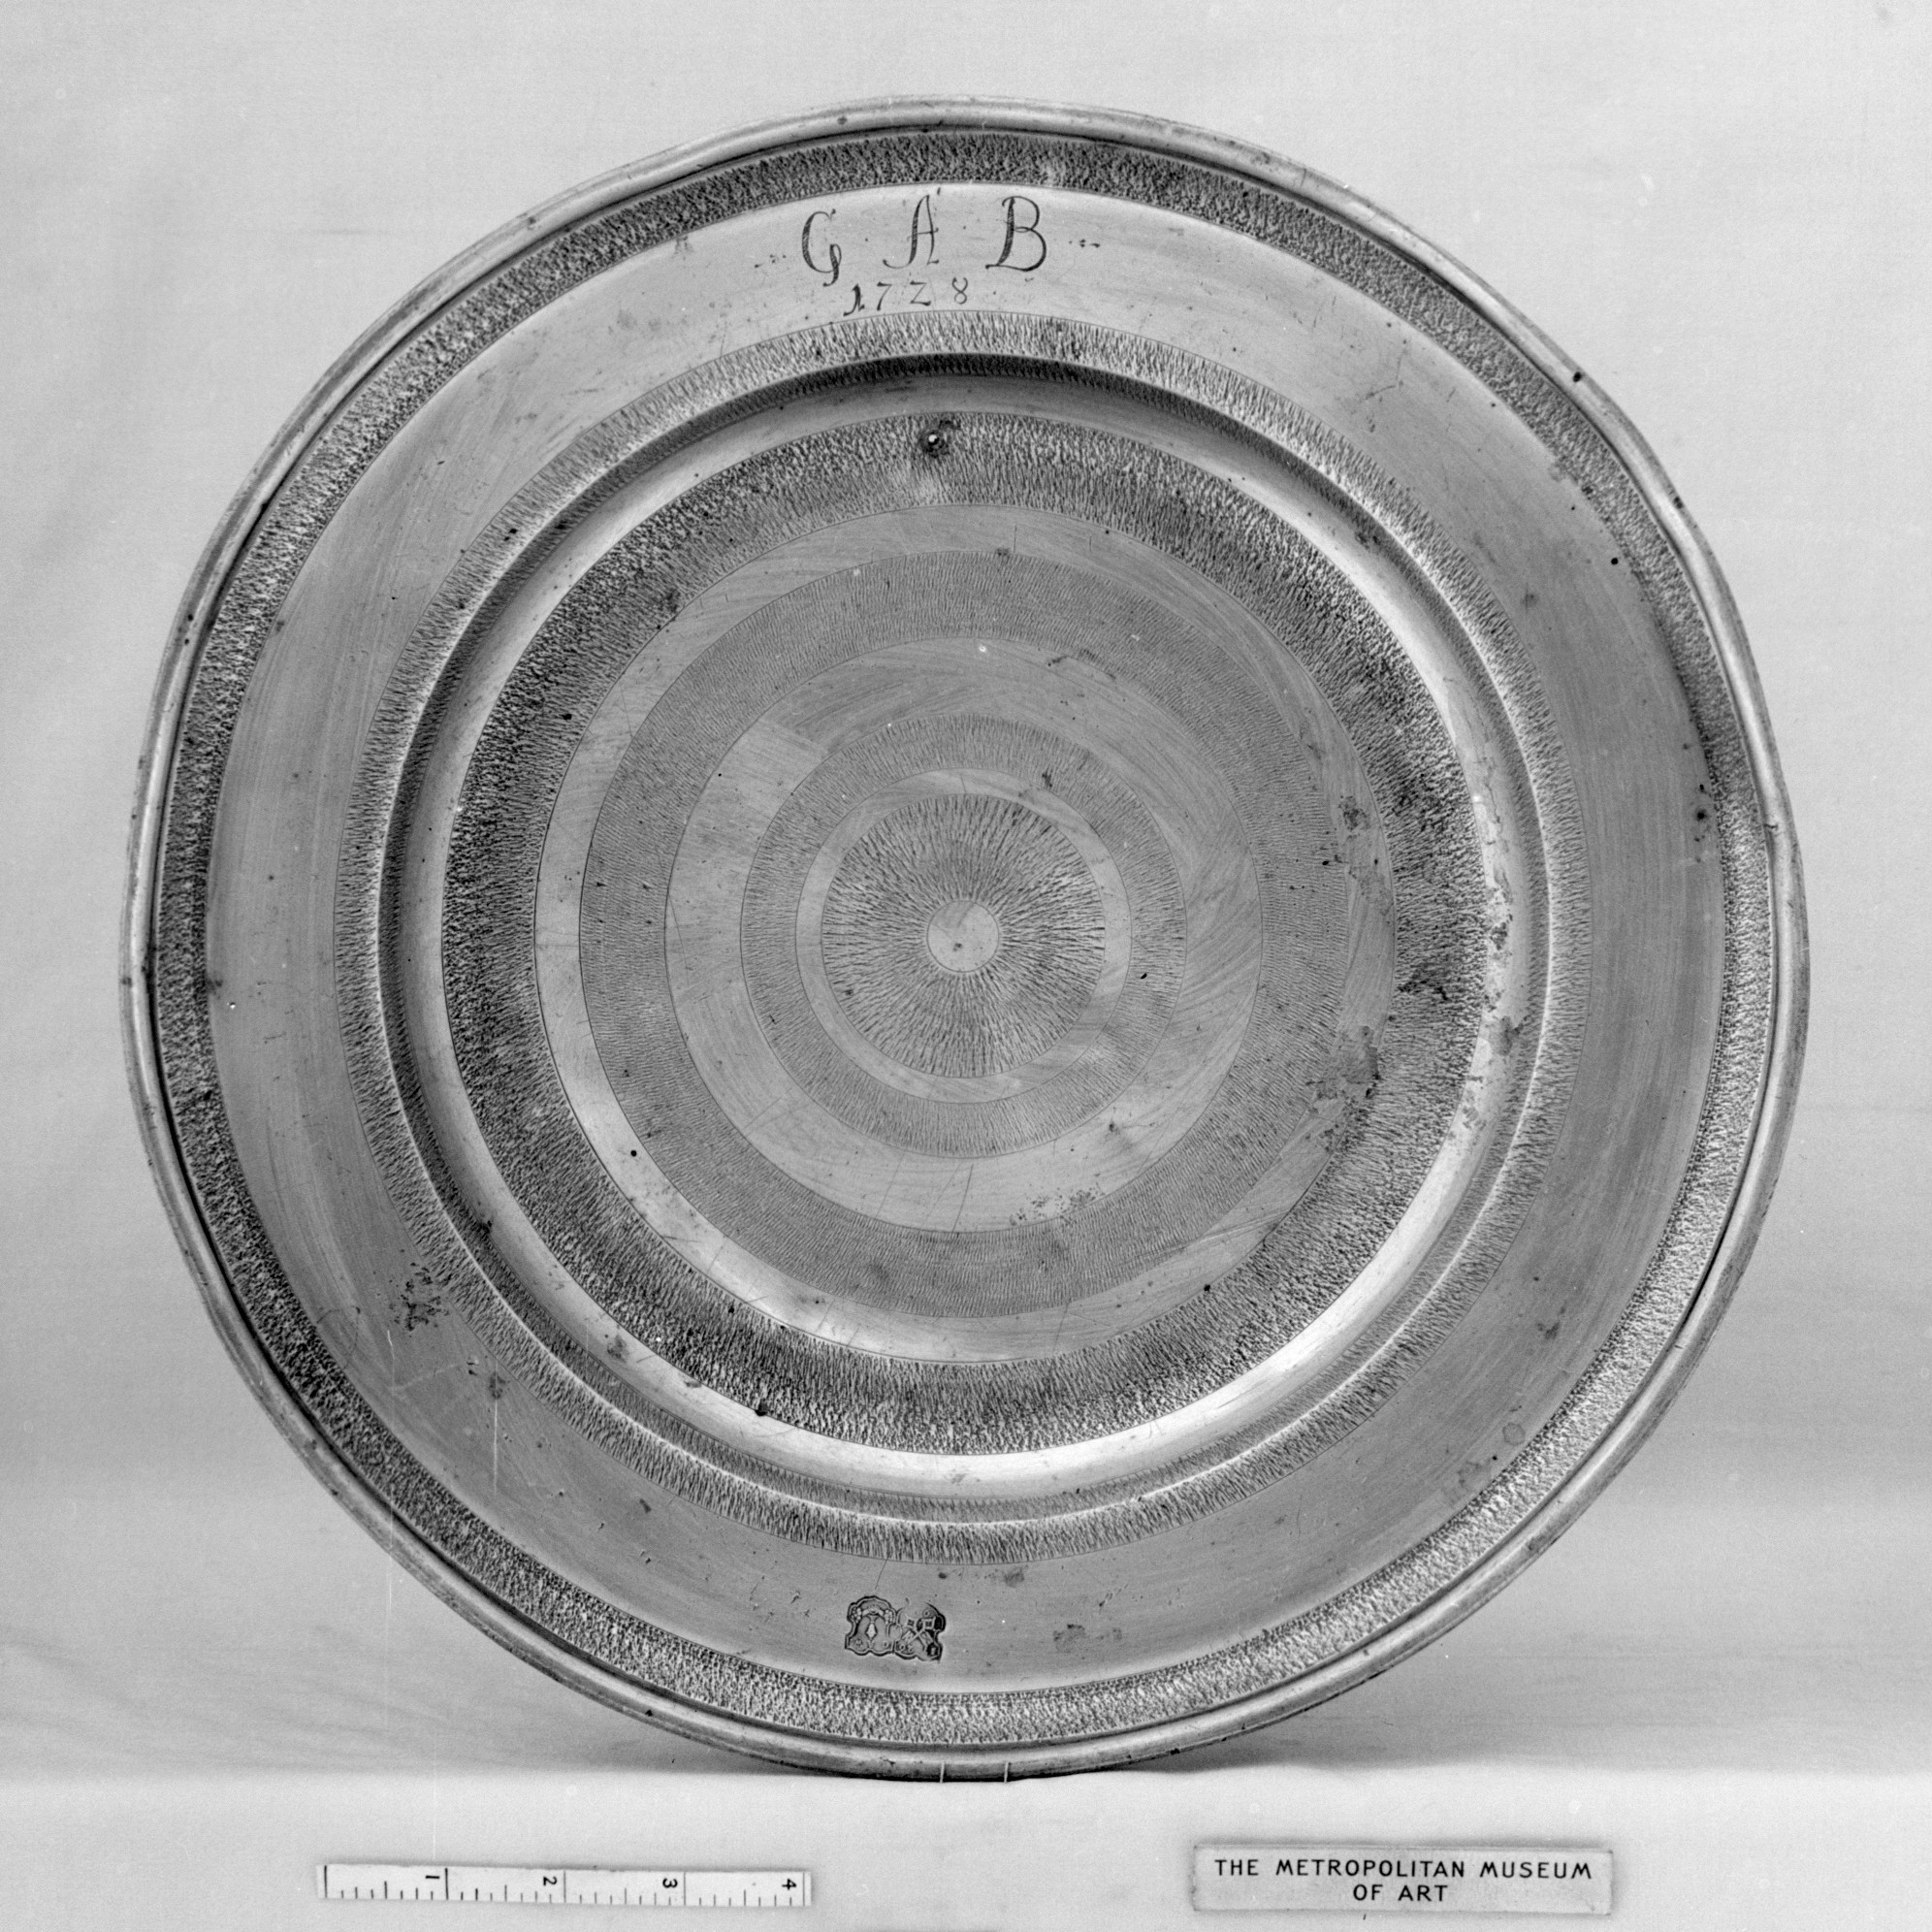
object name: platter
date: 1701-1800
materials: pewter